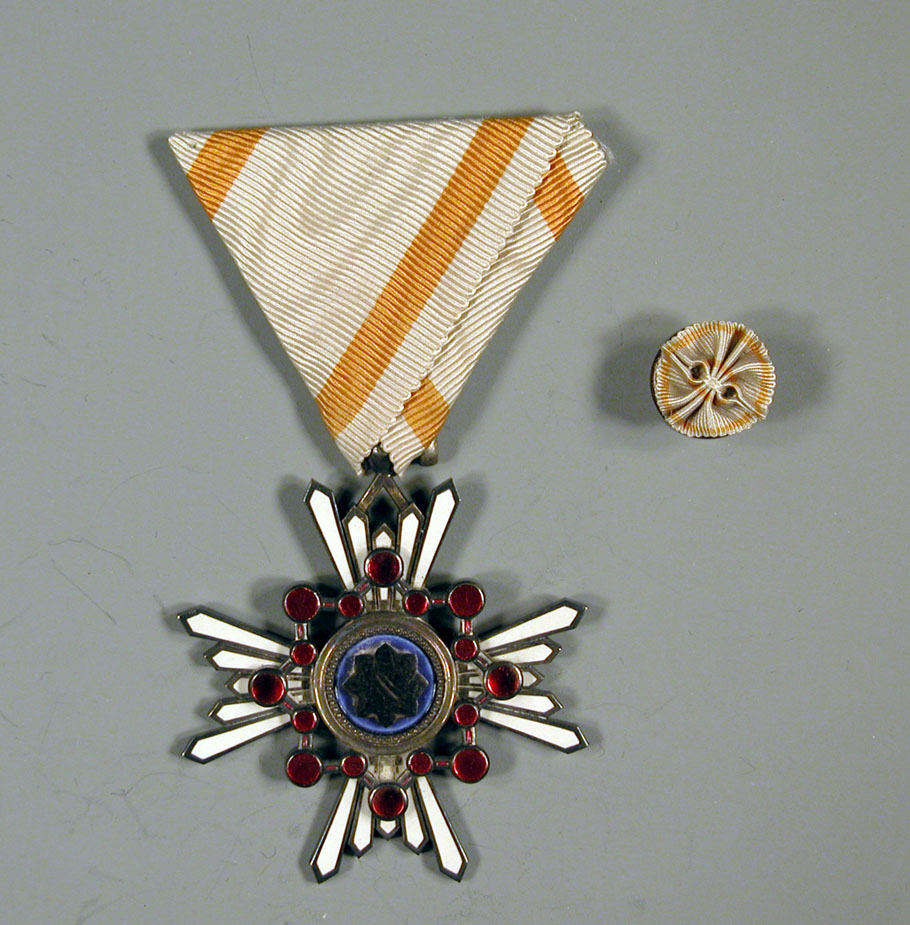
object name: medal and button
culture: japanese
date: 1867-1900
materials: ribbon